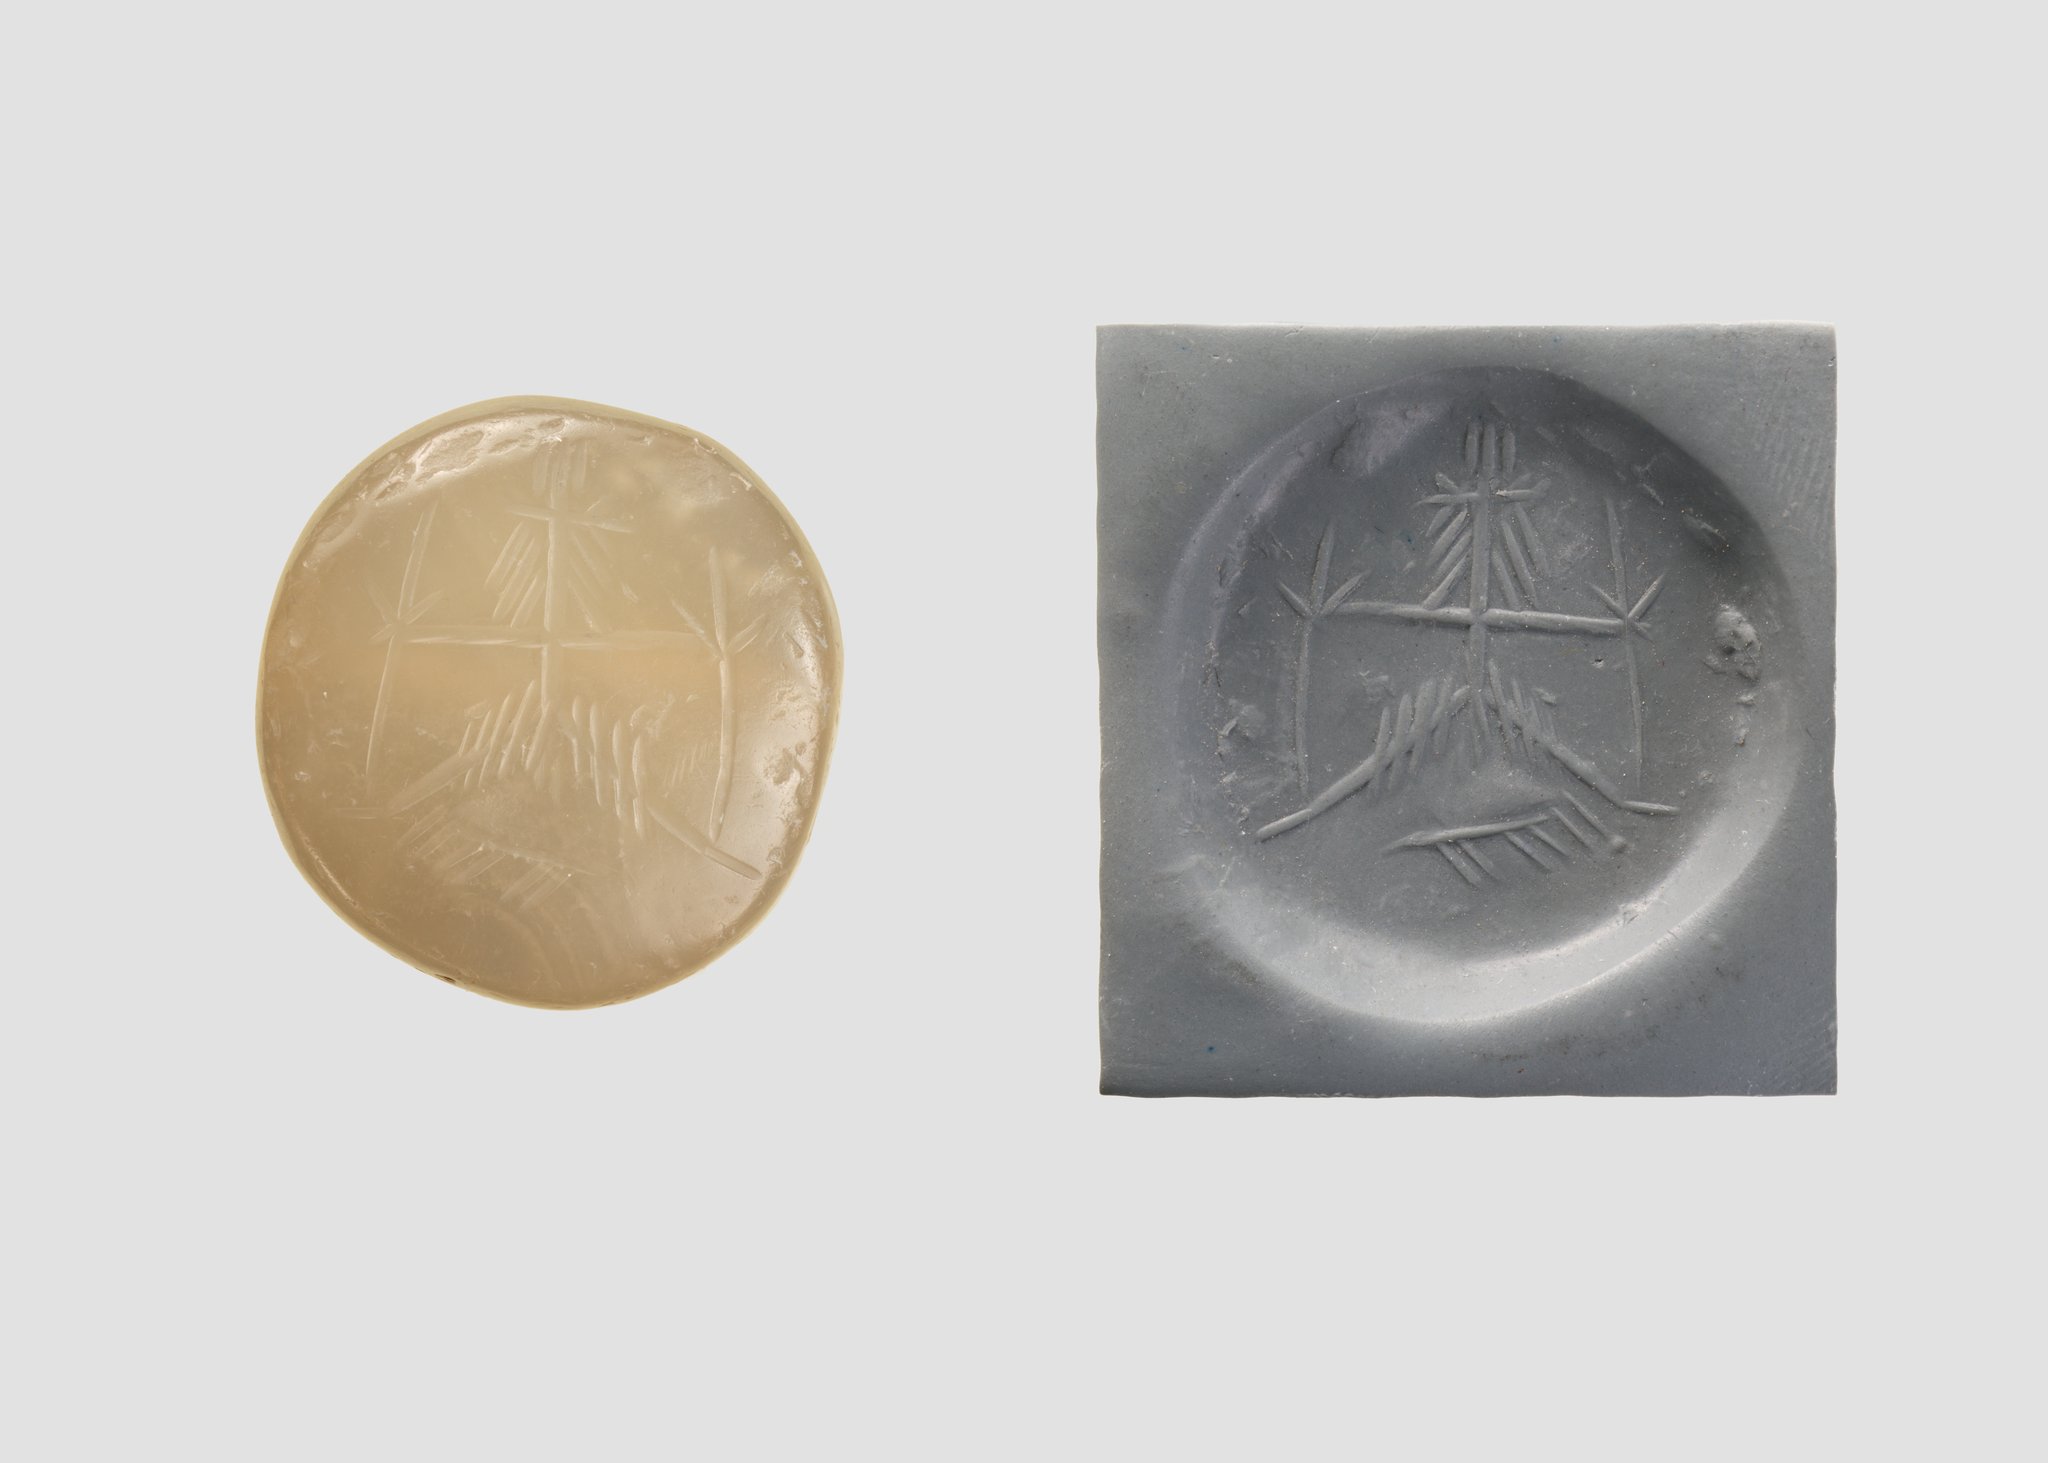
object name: stamp seal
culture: sasanian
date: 201-700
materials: stone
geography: iran